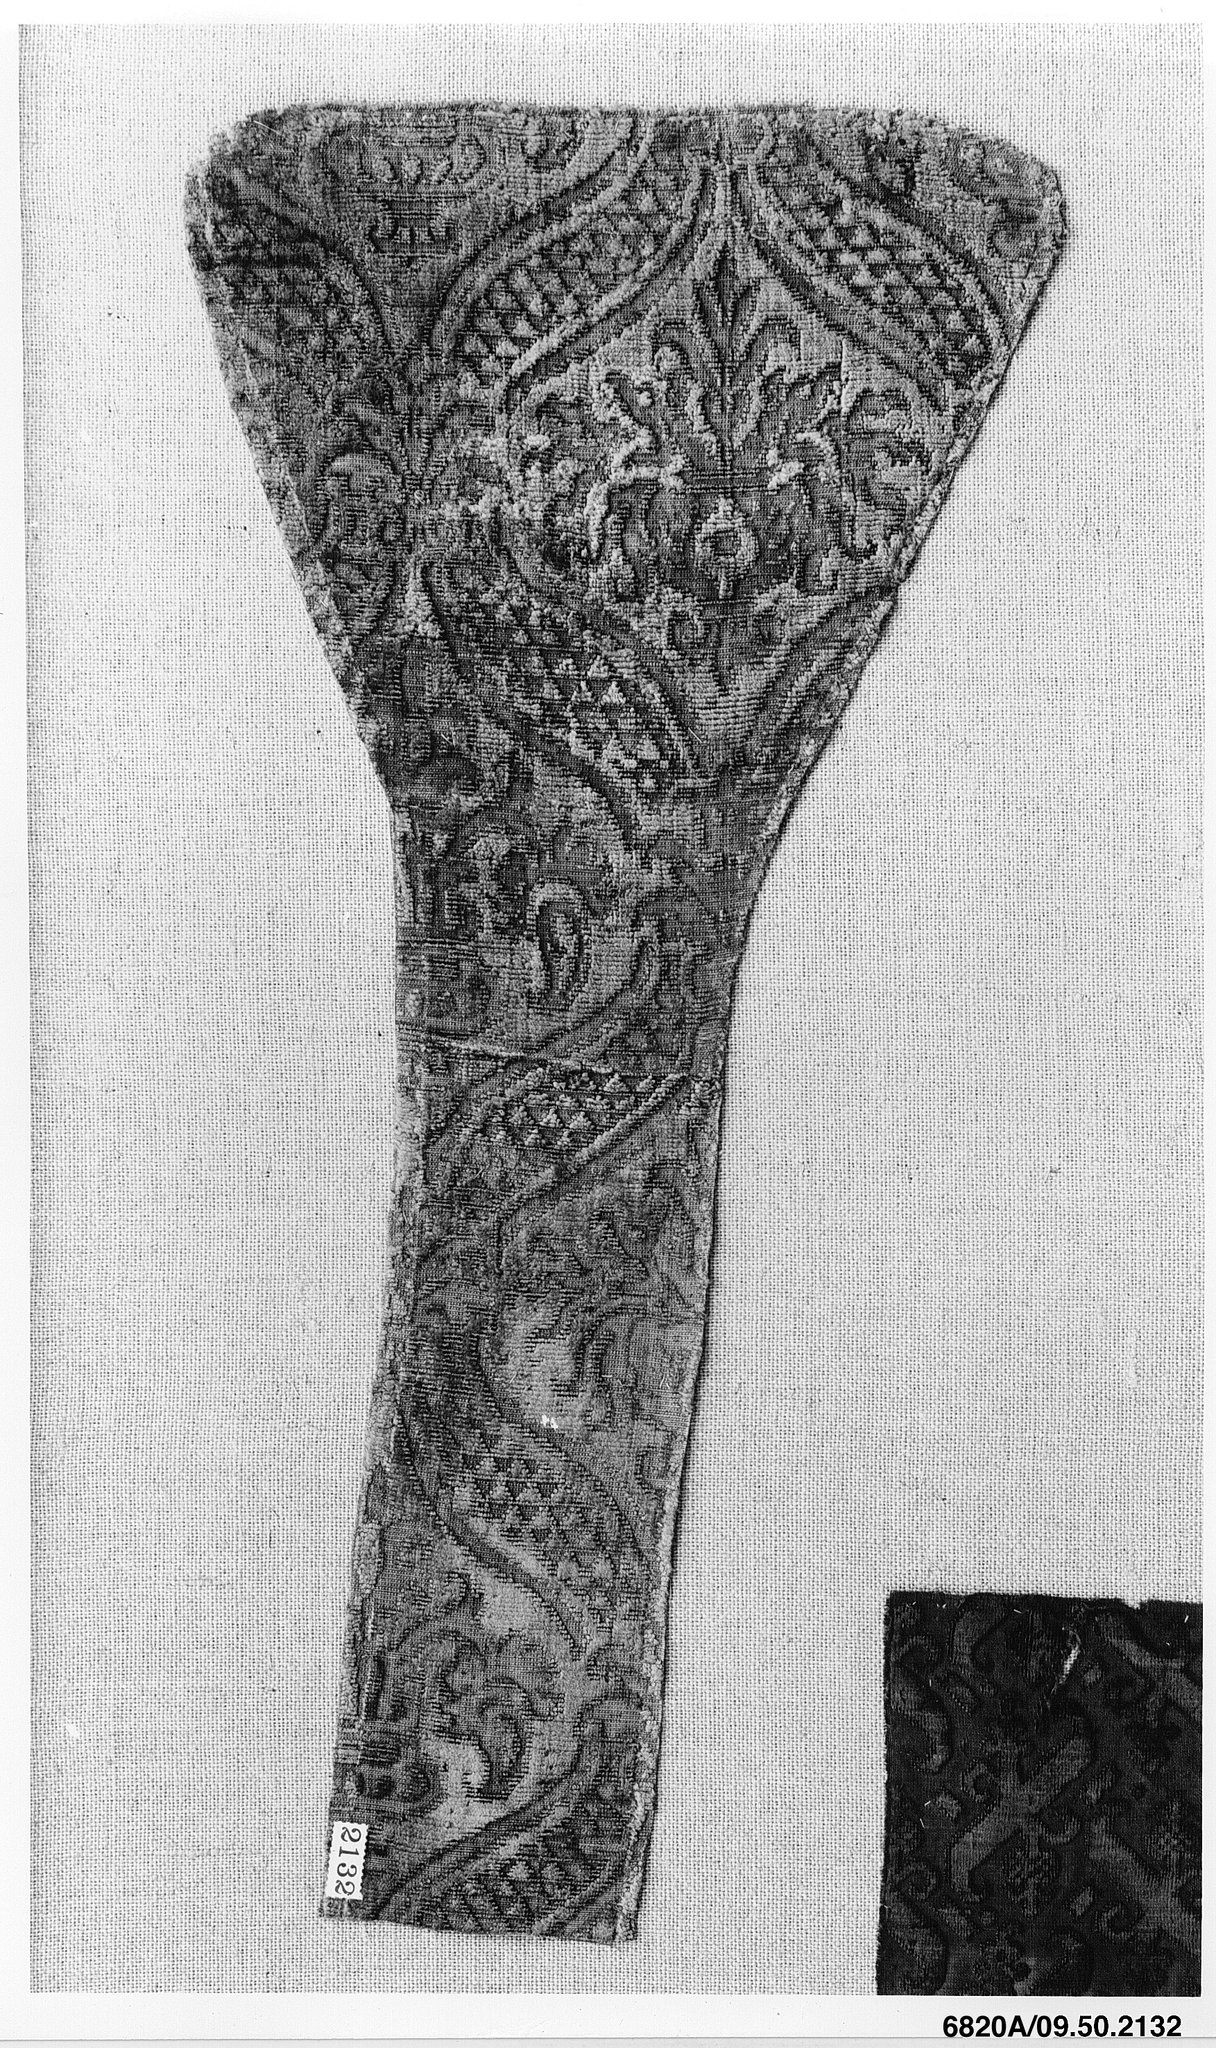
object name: piece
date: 1501-1600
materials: metal thread, silk